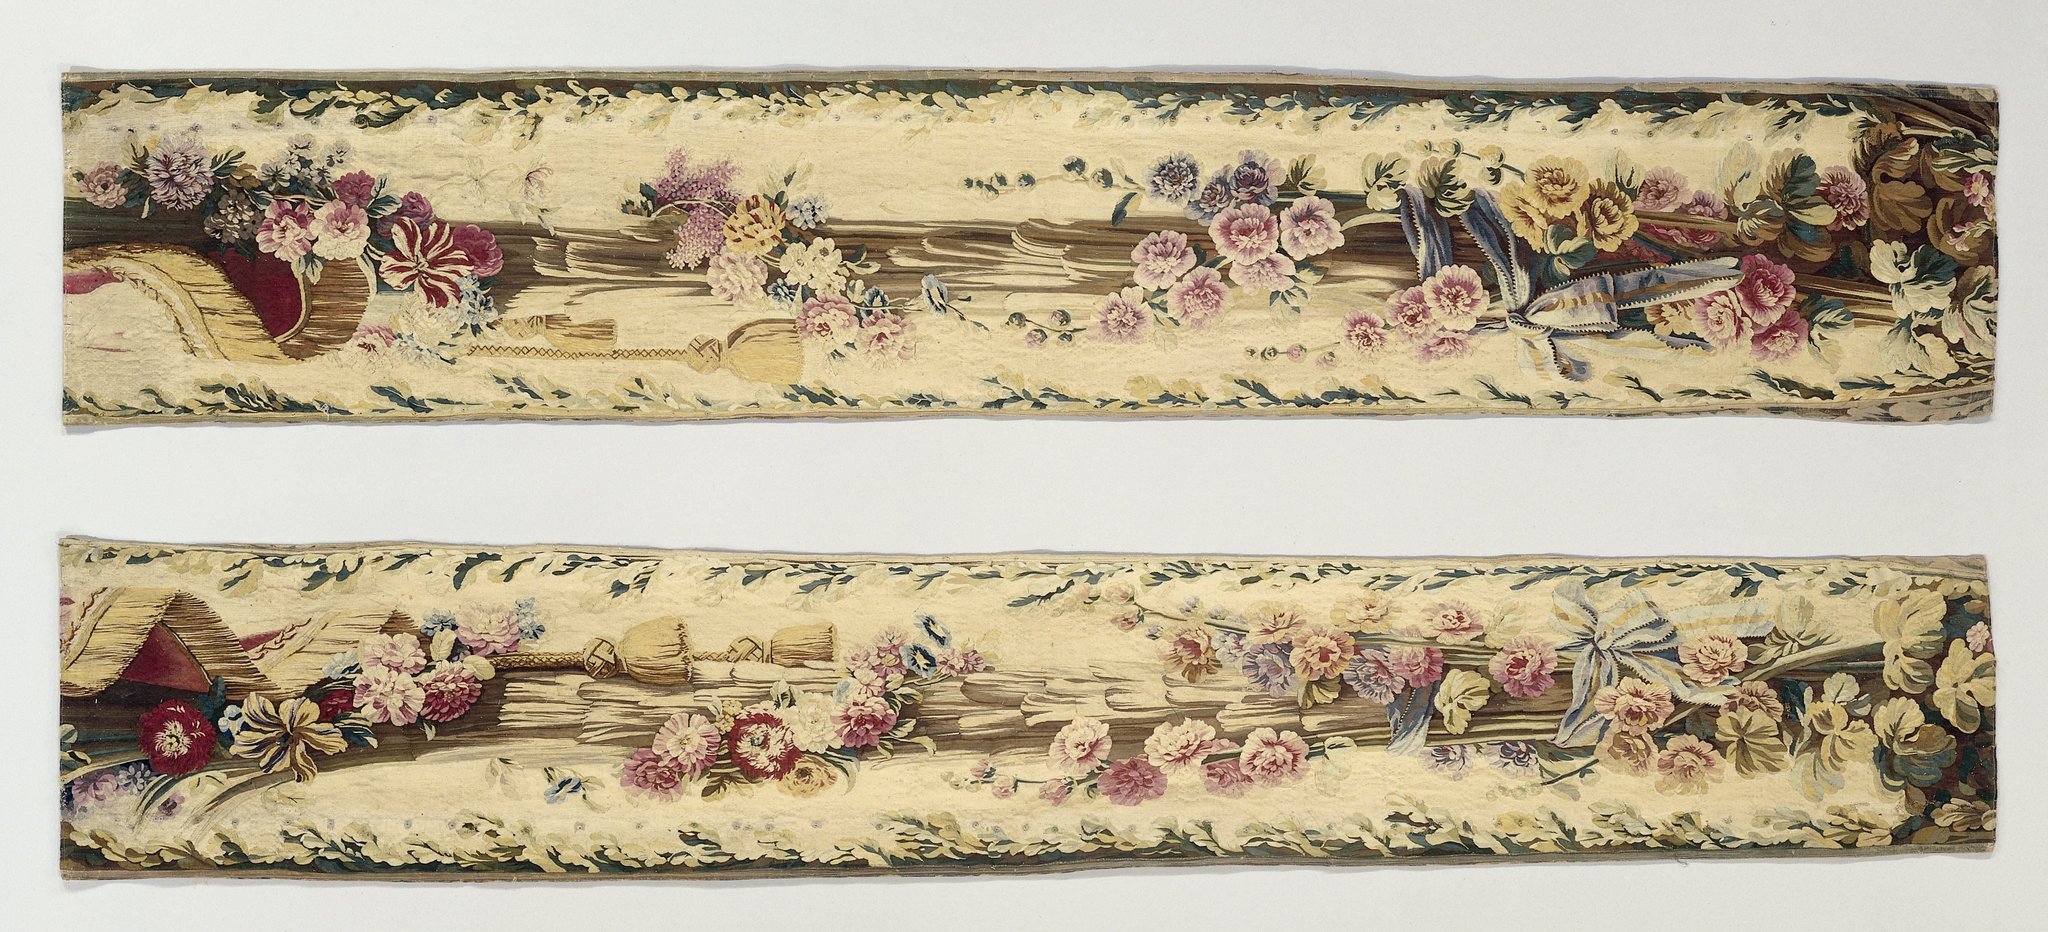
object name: cantonnière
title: Zijstuk van een cantonnière met palmboom, bloemen en draperie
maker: jean baptiste huet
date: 1780-1784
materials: silk, wool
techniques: tapestry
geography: beauvais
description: Lambrekijn van een cantonnière met tegen een crêmewit fond een stam als van een palmboom. Hieromheen een lint dat met een strik is toegeknoopt en een bloemenguirlande. Bij de kruinaanzet de onderkant van een donkerrood gordijn, waar koorden met kwasten van neerhangen.